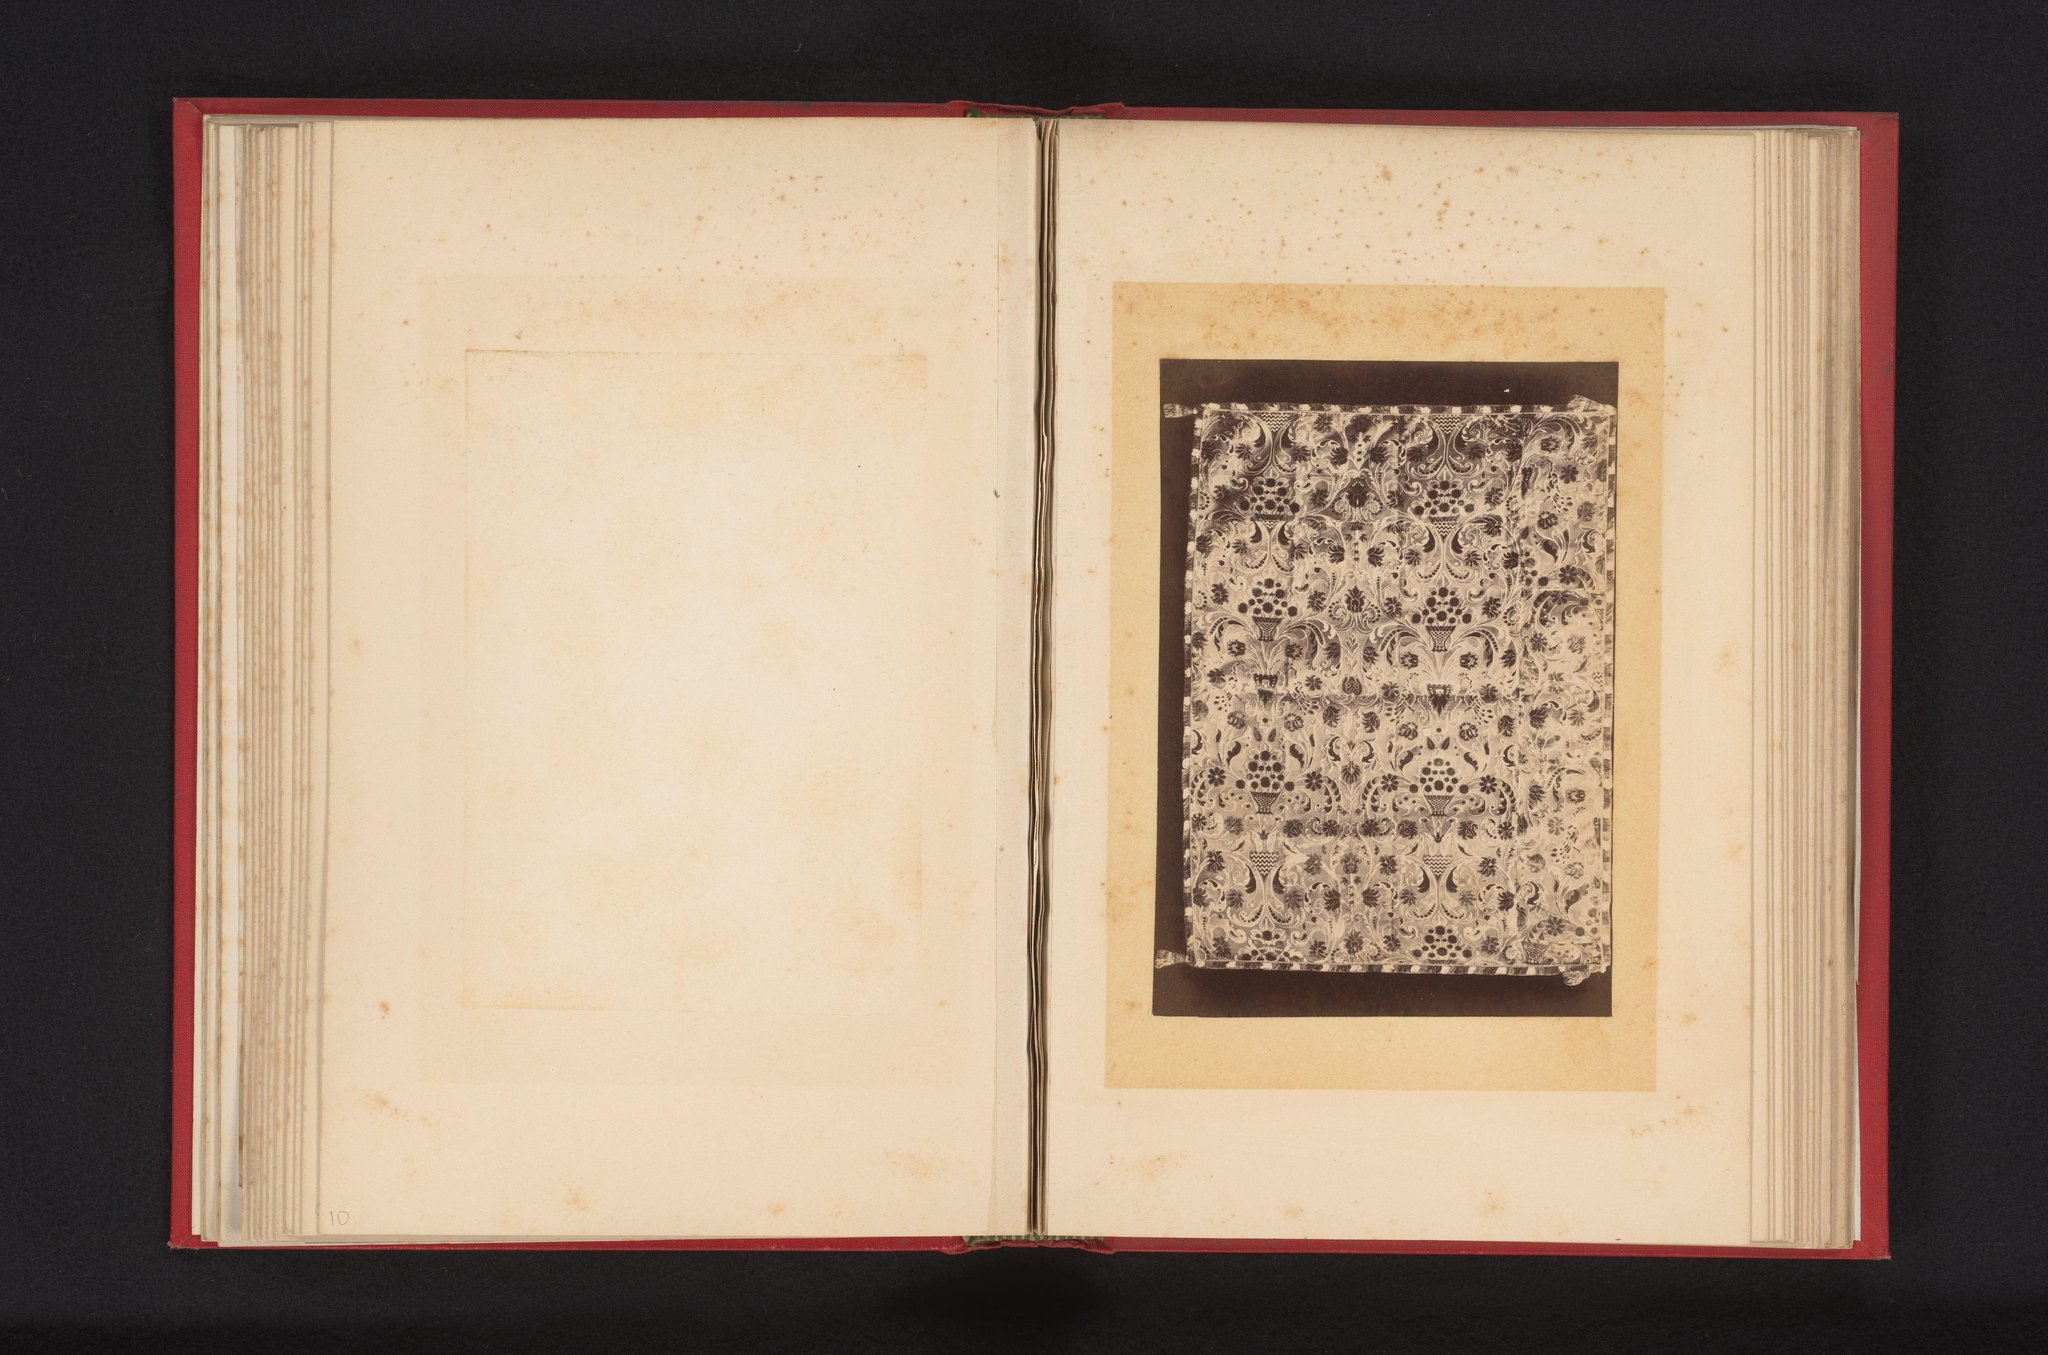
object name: page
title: Tapijt of sprei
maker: Anonymous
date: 1873-1878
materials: photographic support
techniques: albumen print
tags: blanket, carpet, rug